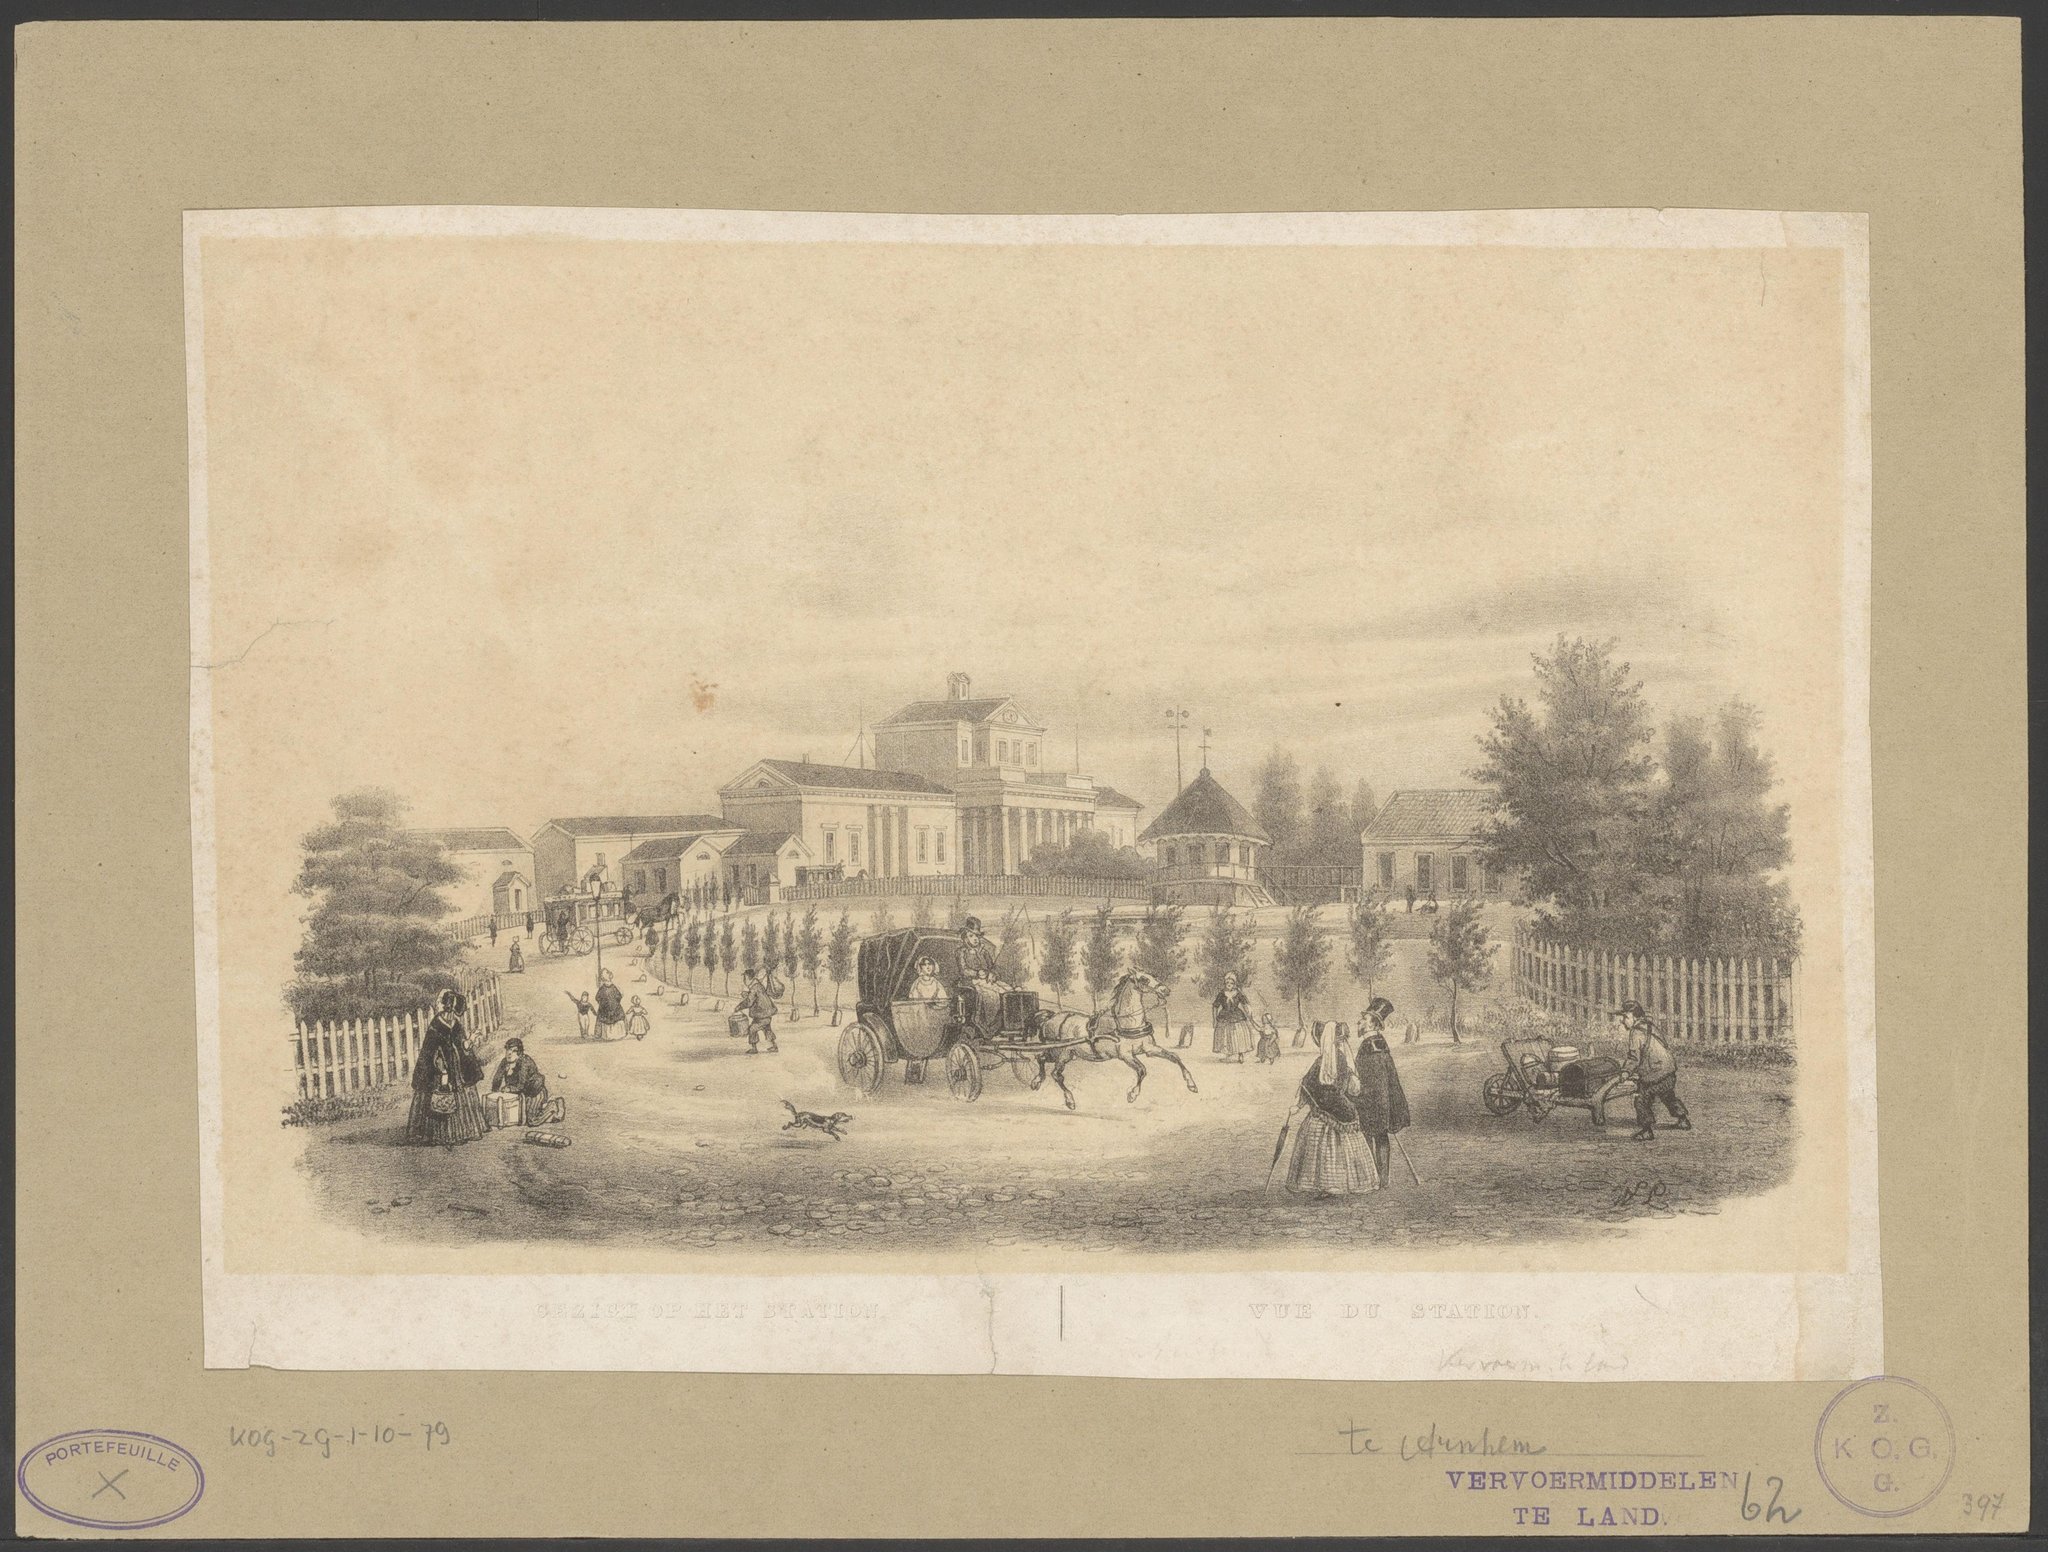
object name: print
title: Gezicht op het station / Vue du station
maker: hendrik wilhelmus last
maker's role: print maker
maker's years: 1817-1873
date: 1827-1873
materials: paper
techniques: tone lithography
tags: four-wheeled vehicle drawn by one animal, city-view in general; 'veduta', station; shelter (railway, tramway), the hague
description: Op de weg naar het station wandelaars en rijtuigen. Onderwerpsrubrieken binnen de Atlas Zeden en Gewoonten: Vervoermiddelen te land en te water, Vervoermiddelen te land, Rijtuigen en Statiekarossen.